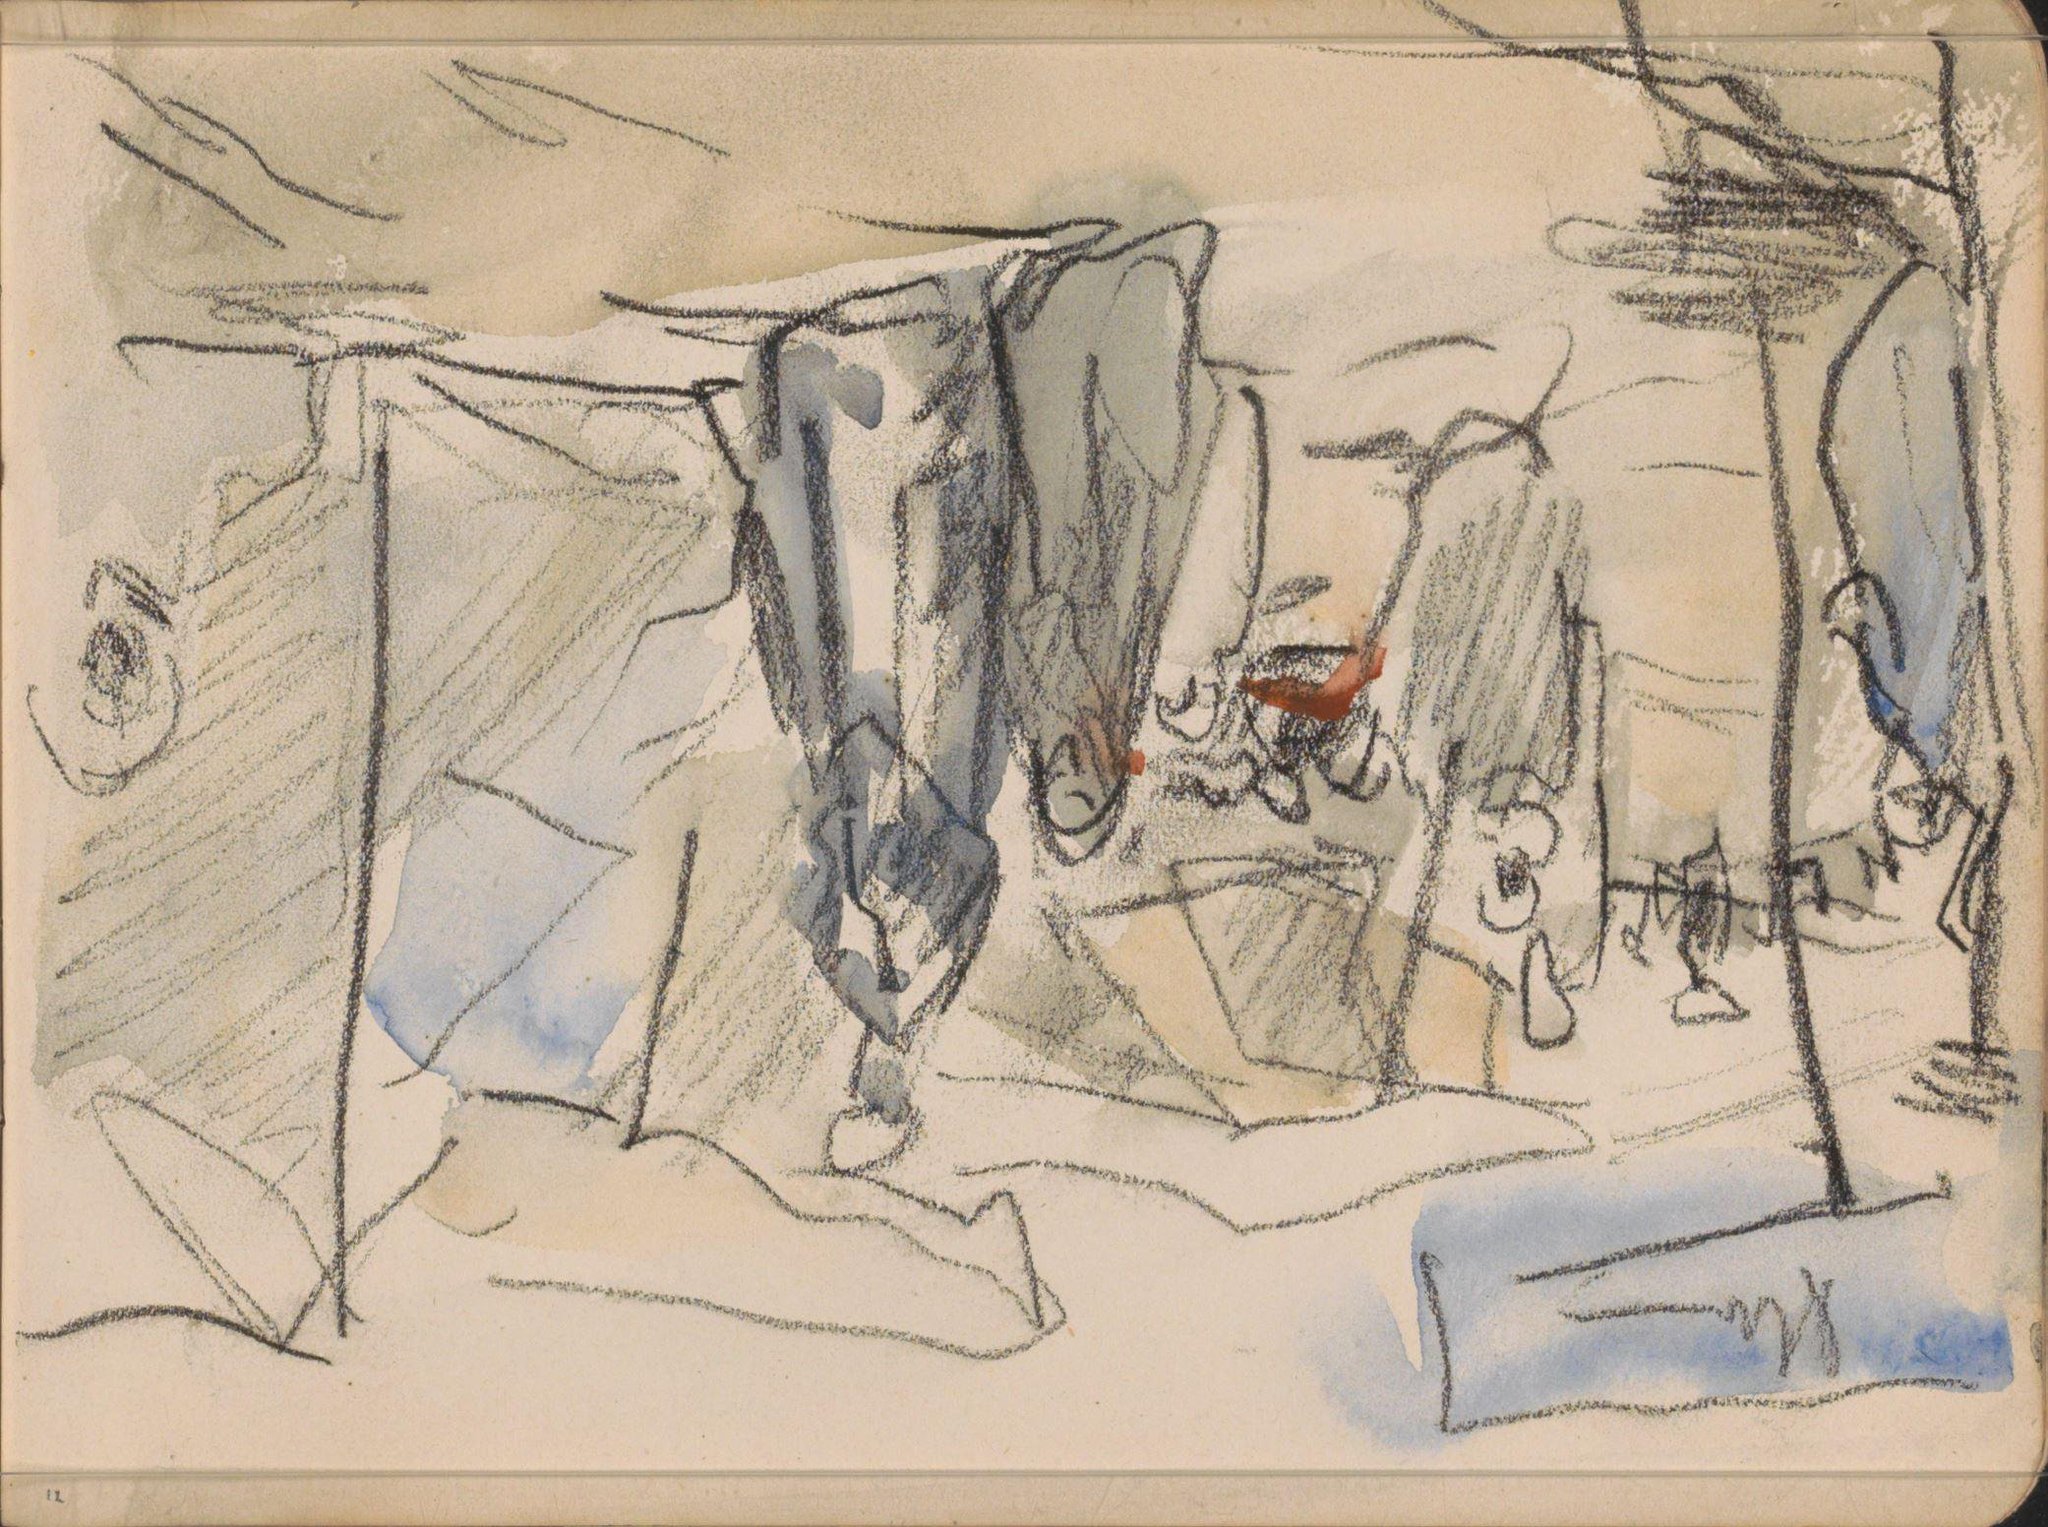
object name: sketchbook leaf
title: Egyptenaren lopend op een weg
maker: marius bauer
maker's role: draughtsman, print maker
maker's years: 1867-1932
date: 1919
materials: chalk, paper, watercolor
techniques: brush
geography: luxor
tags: africans, road, path, walking, parasol, sunshade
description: De figuren dragen traditioneel Noord-Afrikaans kostuum. Langs de weg staan enkele parasols of tenten. Pagina 12 uit een schetsboek met 28 bladen.